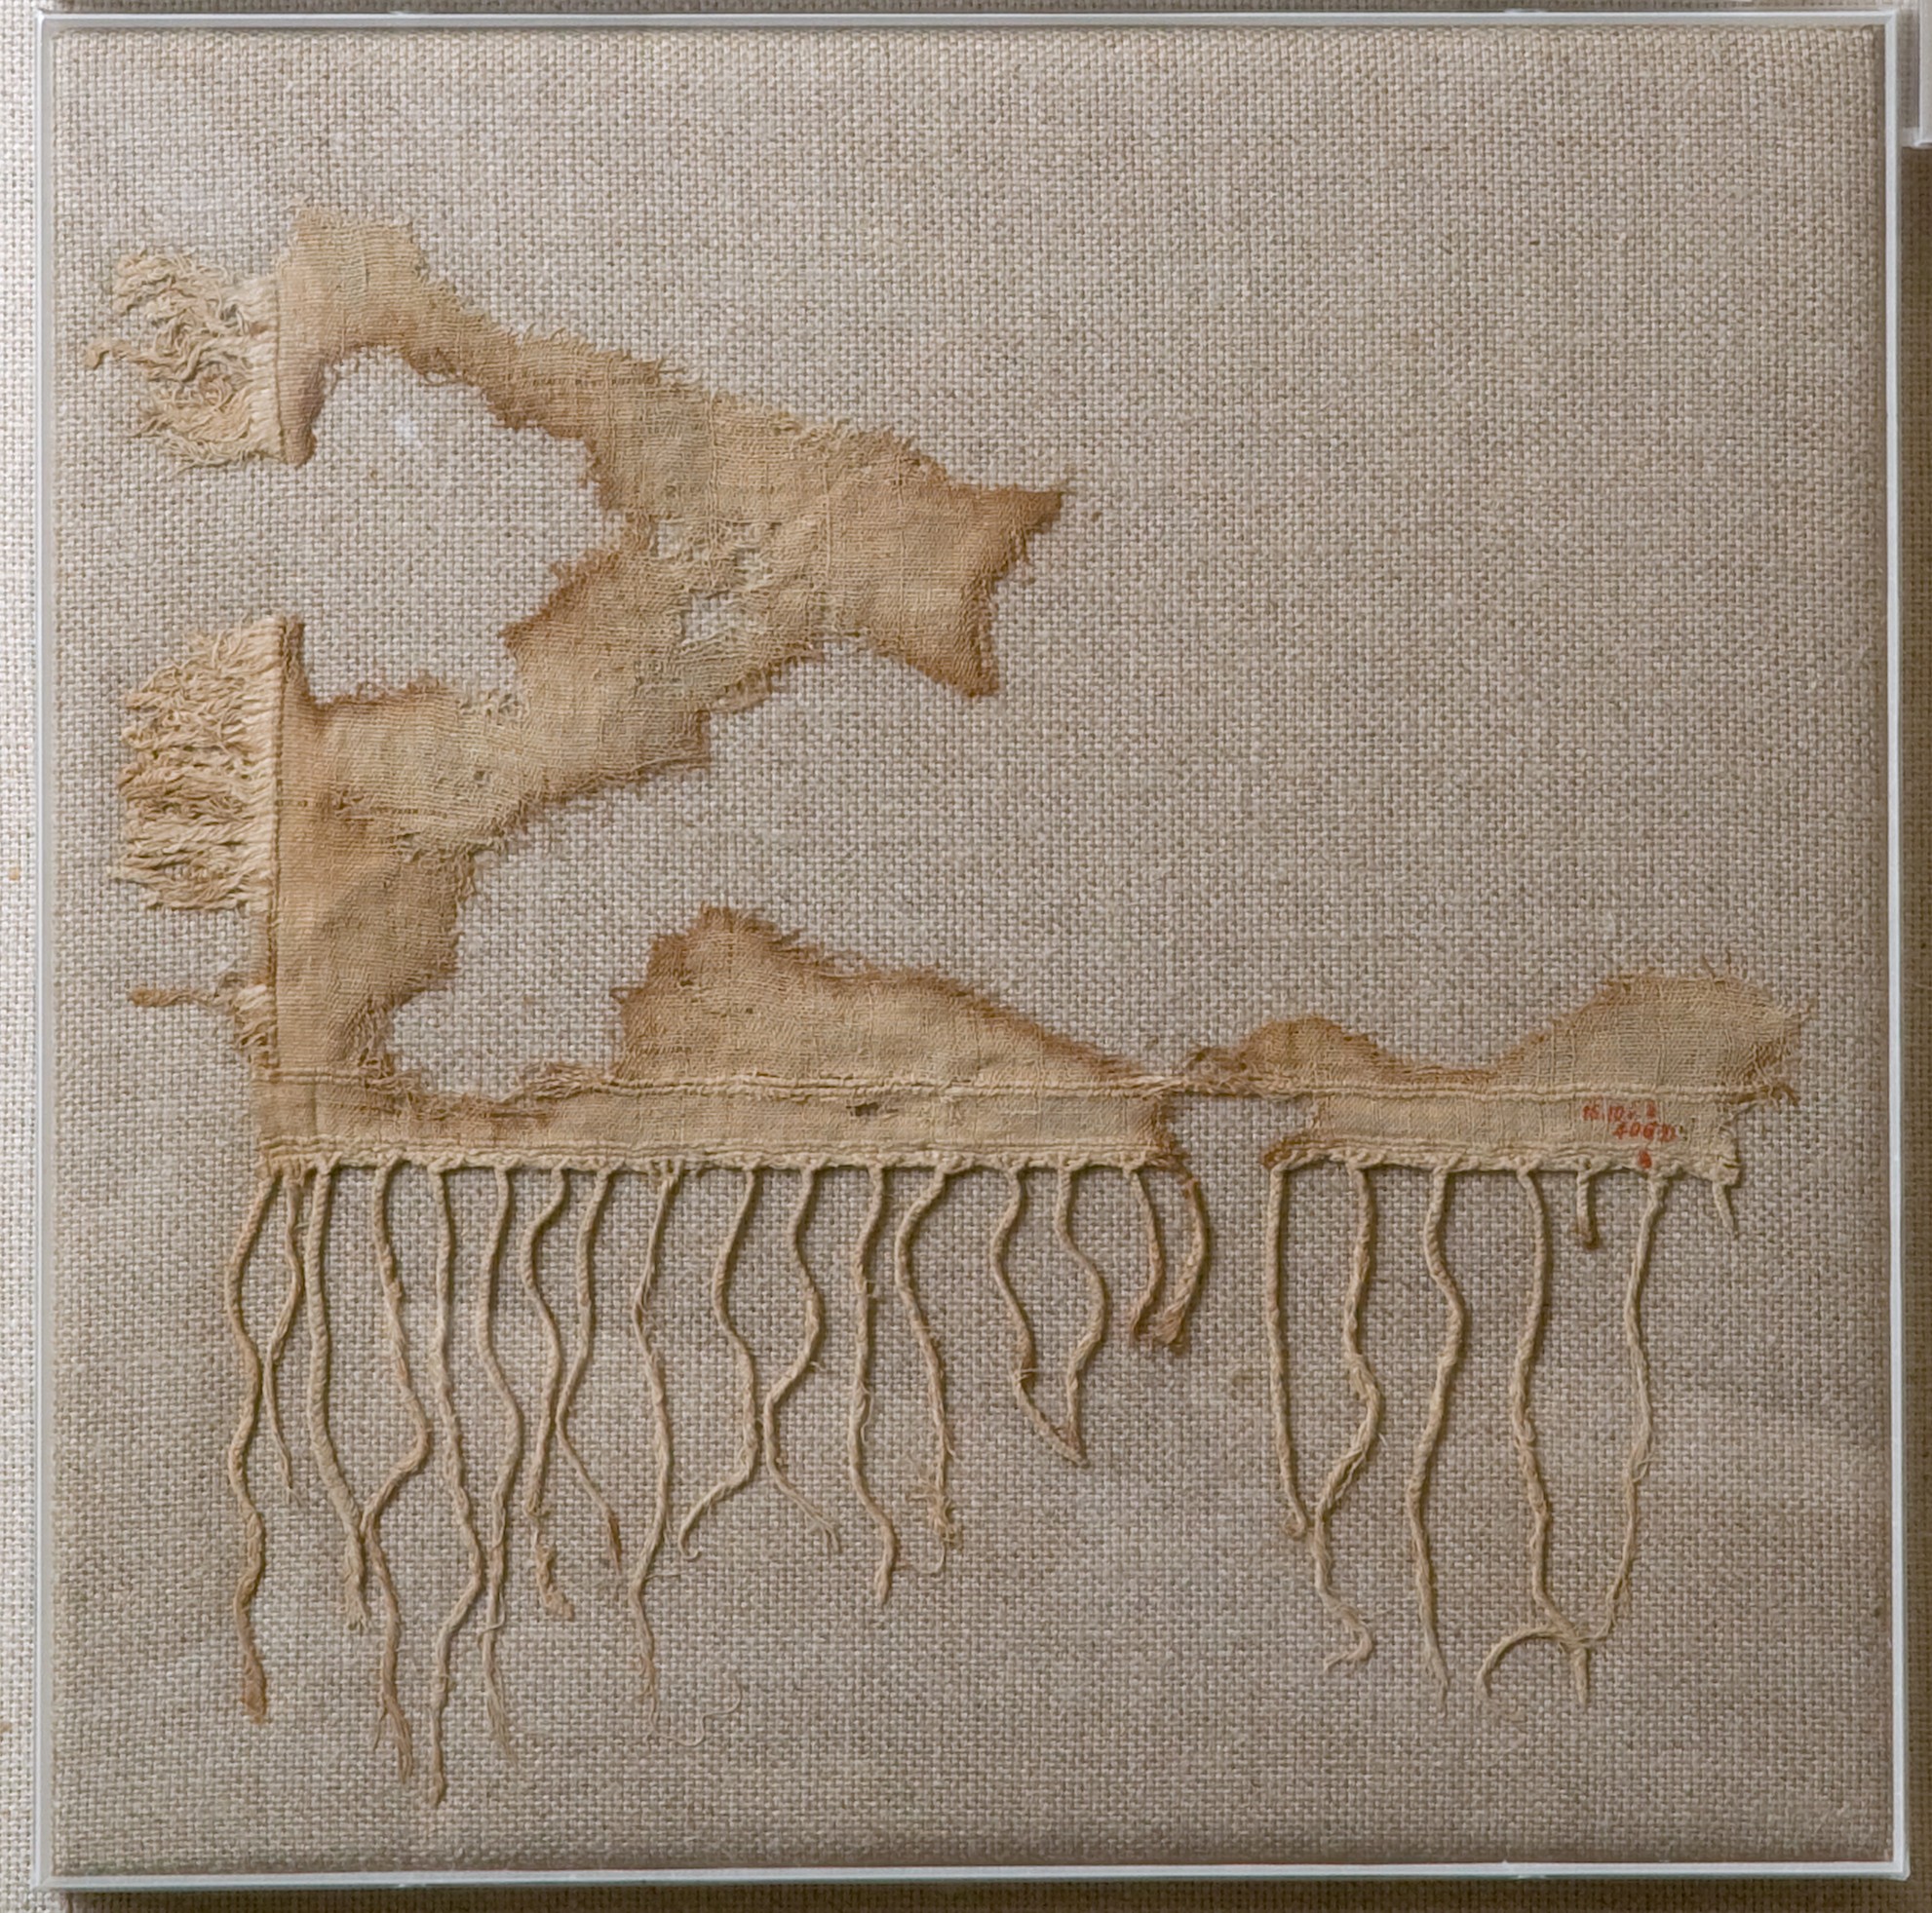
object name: linen fragment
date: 1635-1458 BCE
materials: linen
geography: egypt